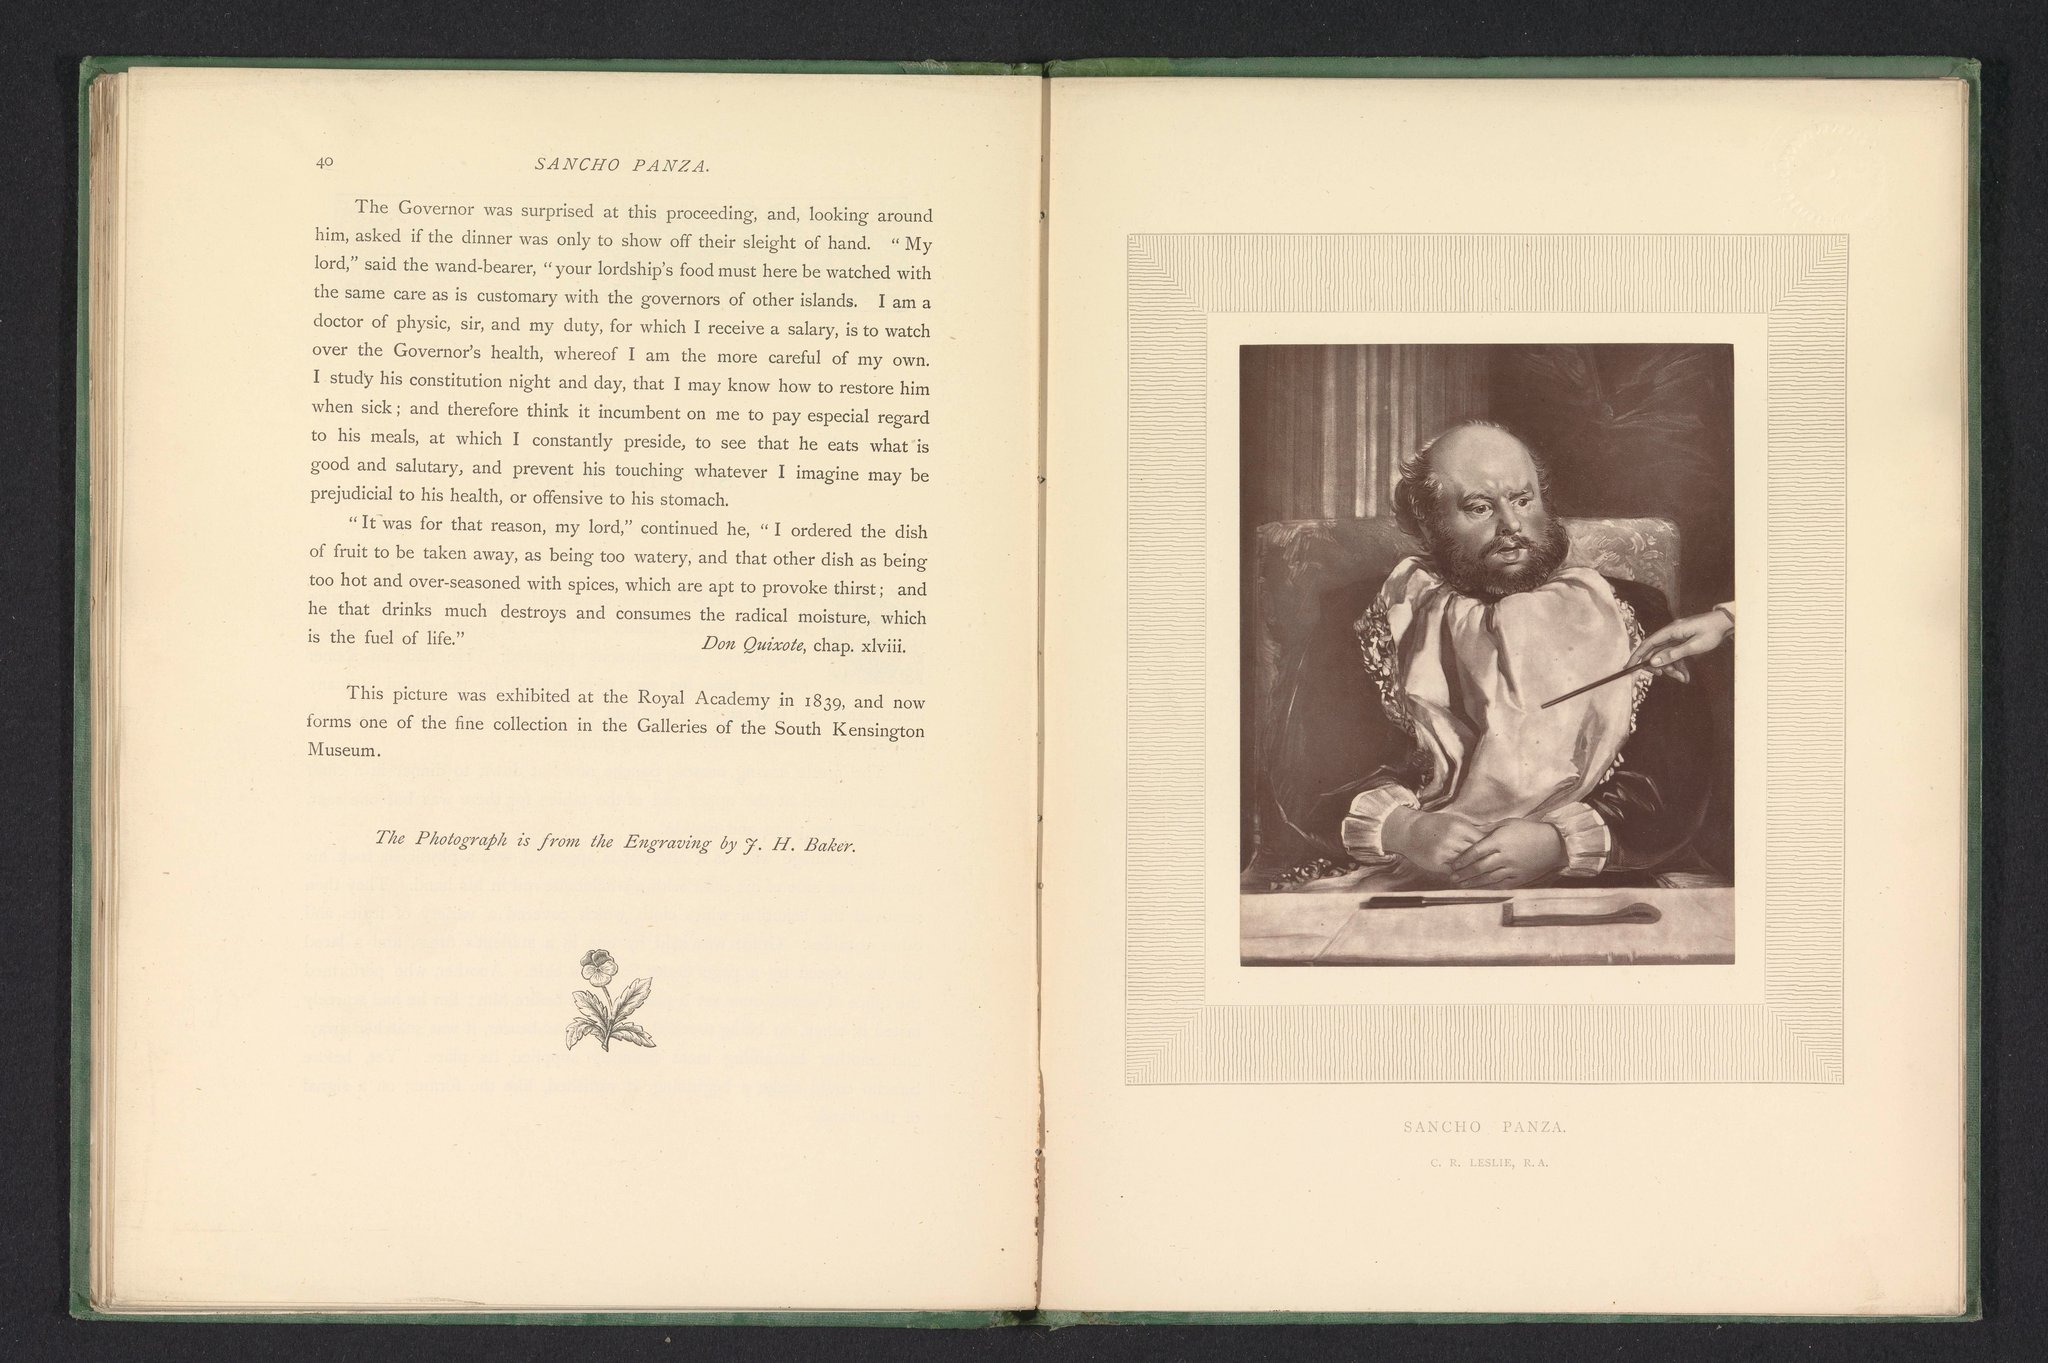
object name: photomechanical print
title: Sancho Panza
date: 1863-1873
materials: paper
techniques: woodburytype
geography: london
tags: picture, painting, sancho panza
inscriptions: name: ‘E[...] 184[...]’